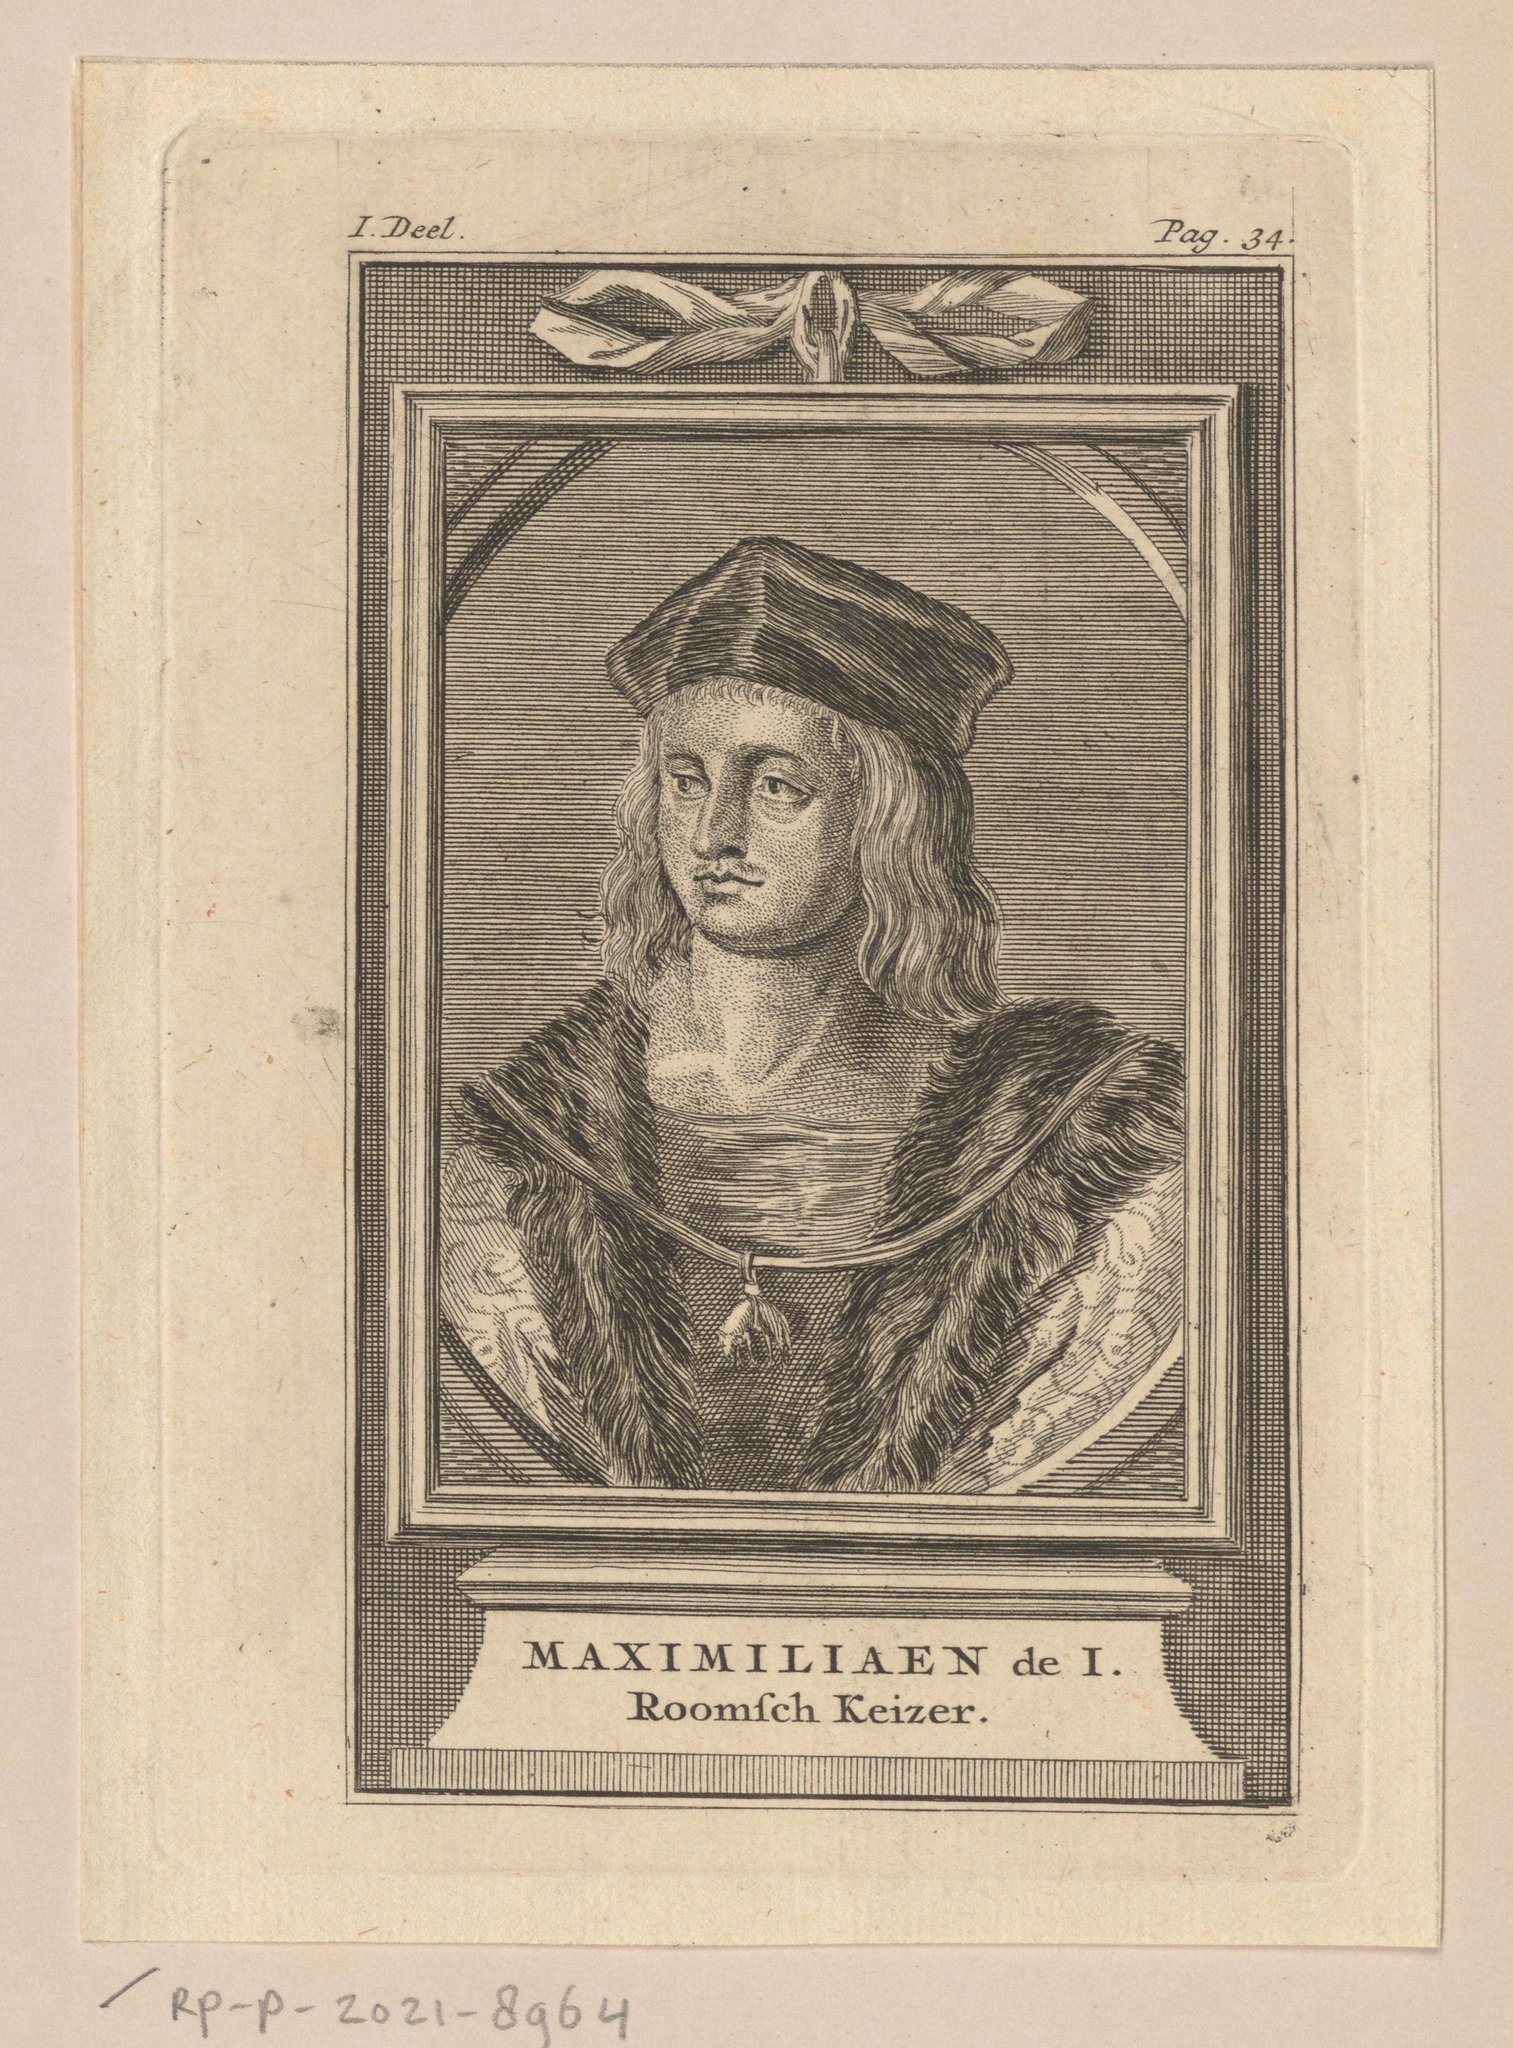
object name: print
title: Portret van keizer Maximiliaan I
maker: Anonymous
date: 1738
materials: paper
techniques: etching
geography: northern netherlands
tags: maximilian i (holy roman emperor), historical persons, emperor, knighthood order of the golden fleece - insignia of a knighthood order, e.g.: badge, chain (with name of order)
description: Prent waarschijnlijk uit: Leti, Gregorio. Het leven van keizer Karel, den Vyfden (...). Leiden: Jan en Hendrik van der Deyster, Amsterdam: Jan Roman de Jonge, 1738.